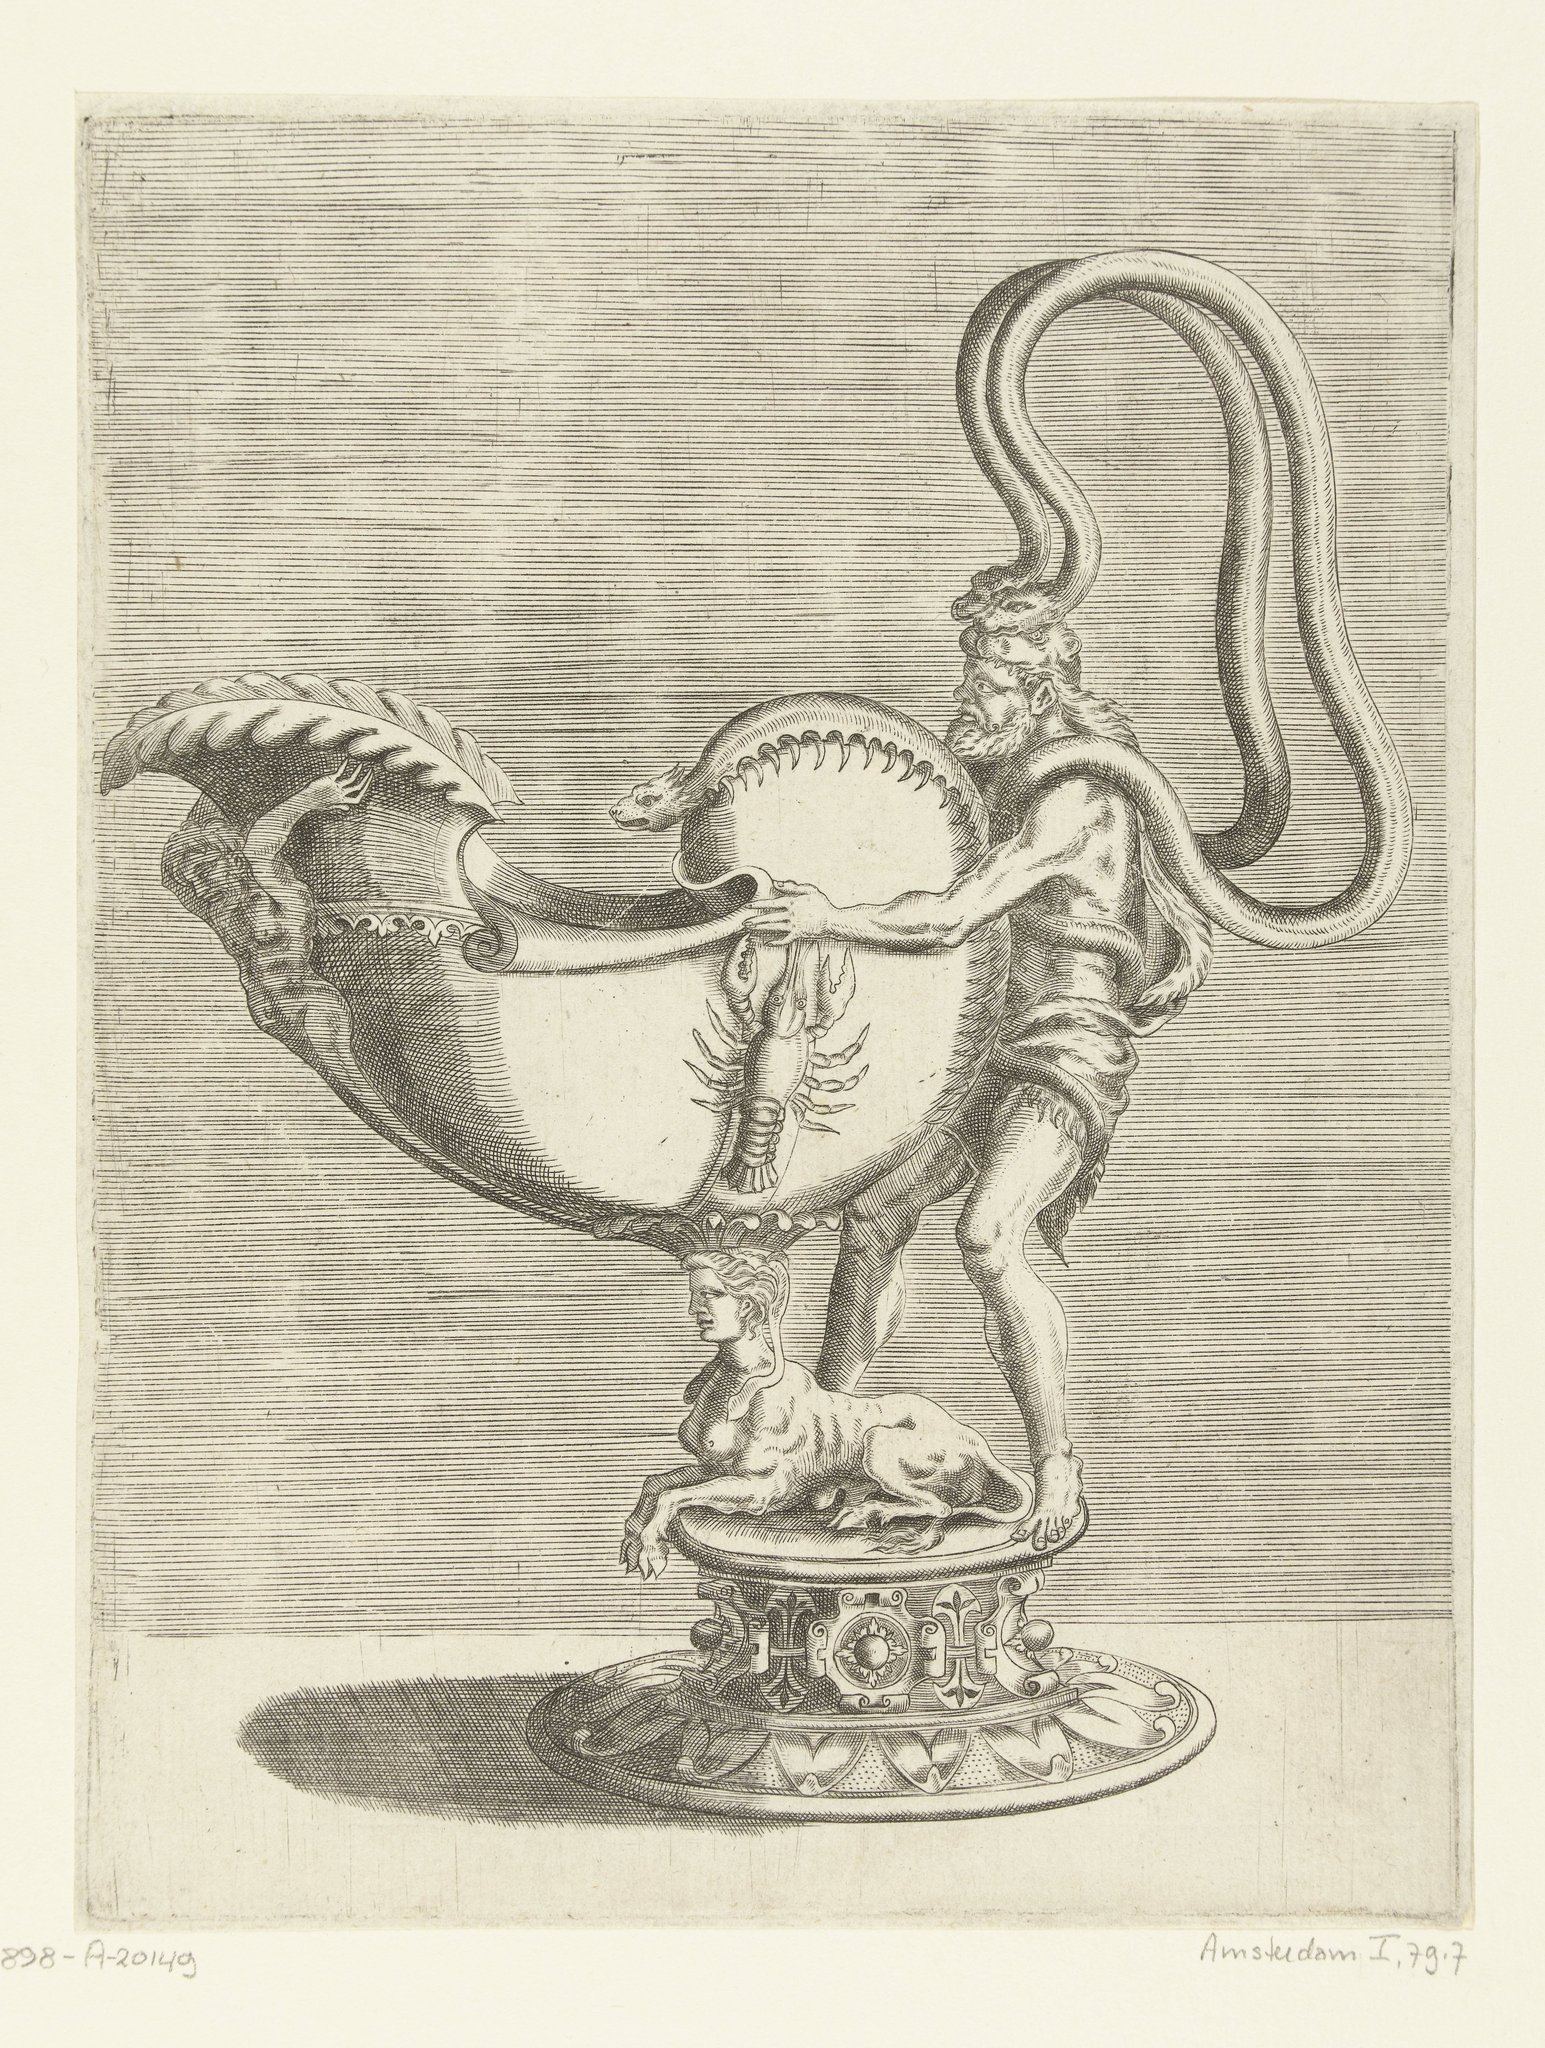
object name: ornament print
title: Nautilusbokaal met een kreeft op de buik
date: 1548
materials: paper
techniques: engraving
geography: netherlands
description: De bokaal wordt gedragen door een man en ondersteund door een sfinx. De oren worden gevormd door twee slangen die zich van de schouders van de man met een bocht naar zijn hoofd slingeren. Afkomstig uit een serie bestaande uit een titelblad en 20 bladen.